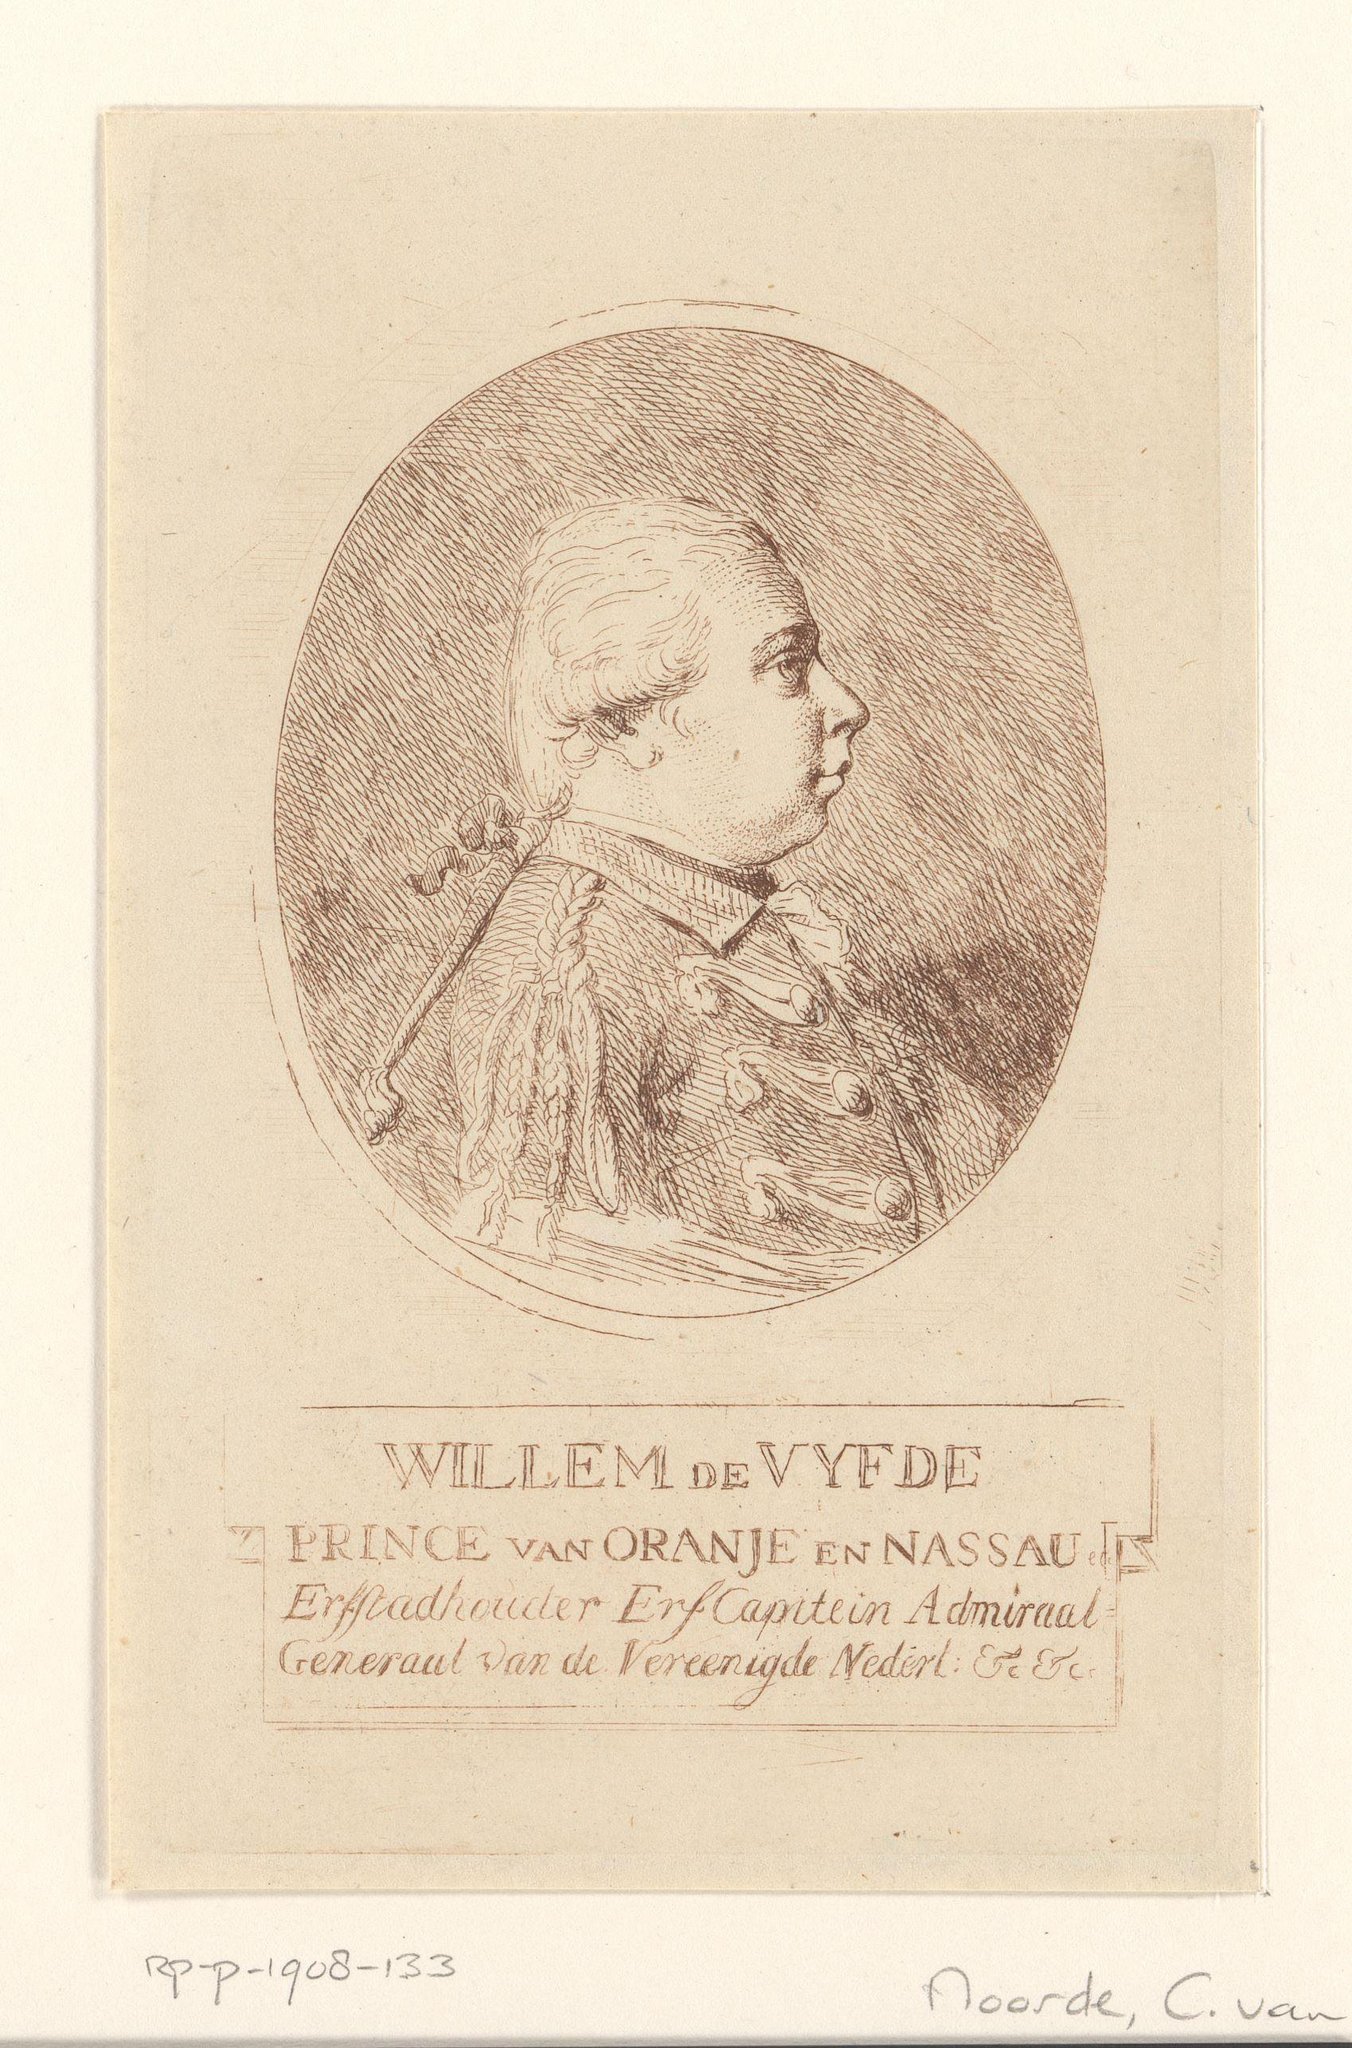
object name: print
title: Portret van Willem V, prins van Oranje-Nassau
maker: cornelis van noorde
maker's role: draughtsman, print maker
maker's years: 1731-1795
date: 1775-1849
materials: paper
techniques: engraving, etching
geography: haarlem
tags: the hague, william v (prince of orange)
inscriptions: collector's mark: Lugt 2228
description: De hier vermelde titel verwijst naar de hoogst verkregen titel van de geportretteerde, niet per se naar de titel die de geportretteerde op deze voorstelling draagt.